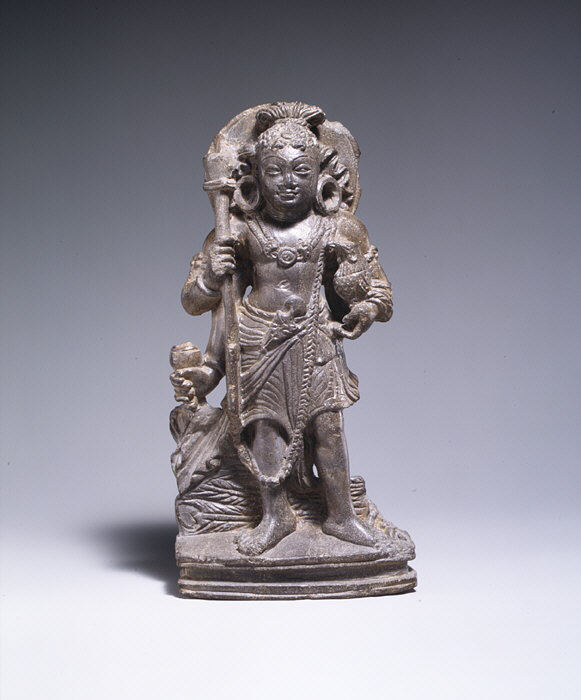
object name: figure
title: Karttikeya, the God of War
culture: gandhara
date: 501-700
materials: stone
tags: kashmir